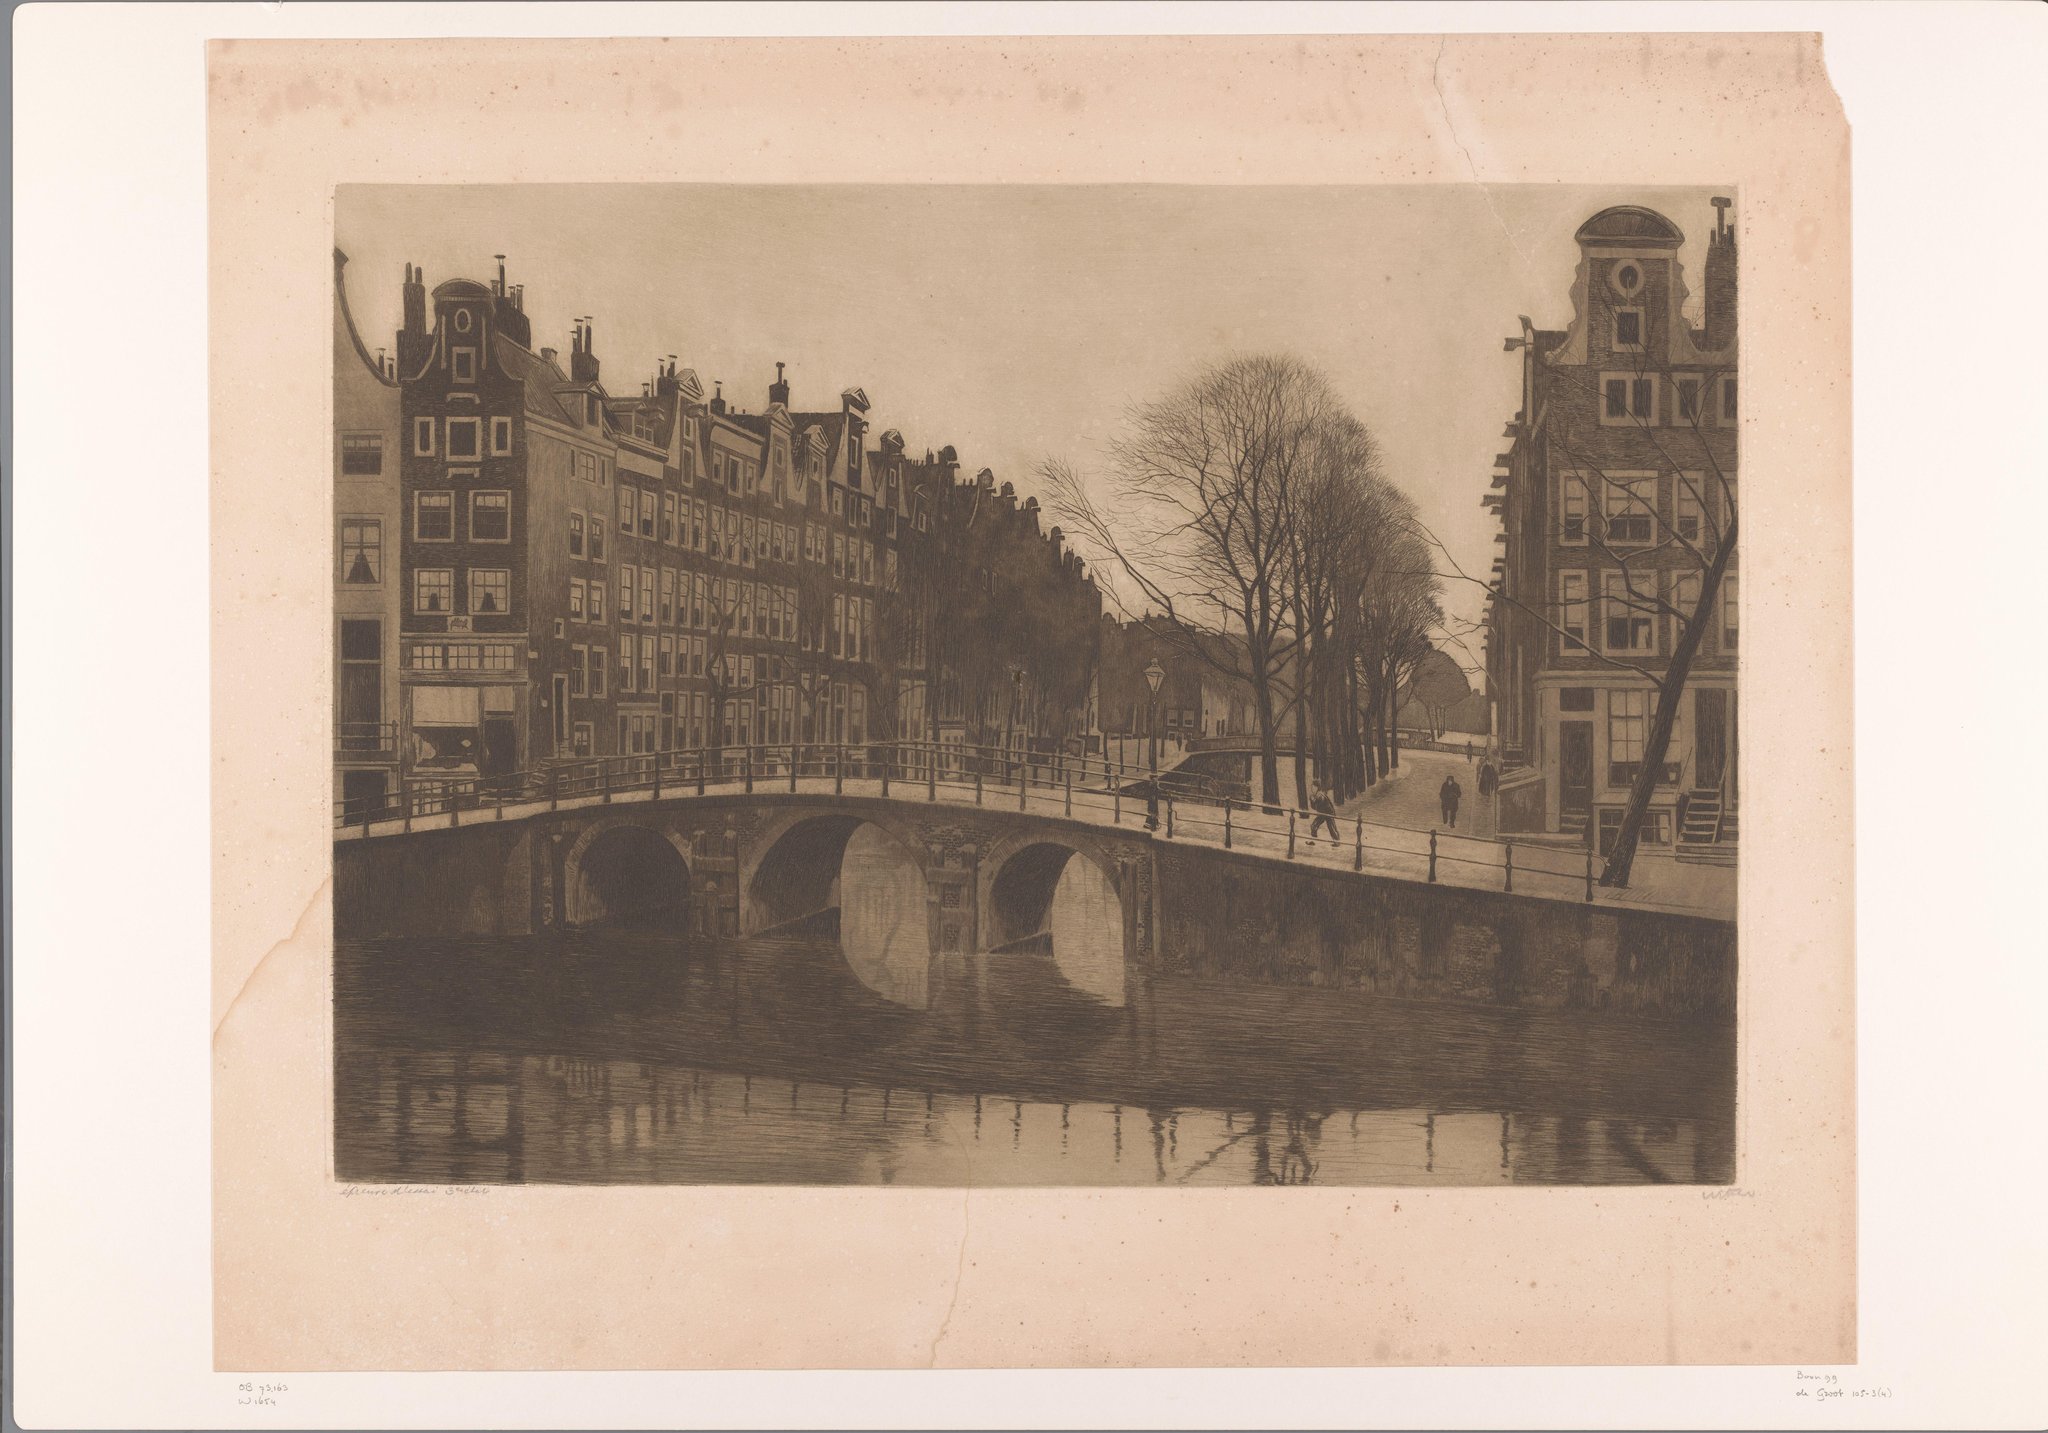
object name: print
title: Leidsegracht te Amsterdam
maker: willem witsen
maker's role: draughtsman, painter, print maker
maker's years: 1860-1923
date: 1901-1902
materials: paper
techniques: aquatint, etching, intaglio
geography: netherlands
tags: canals, waters (in city)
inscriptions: collector's mark: Lugt 2228